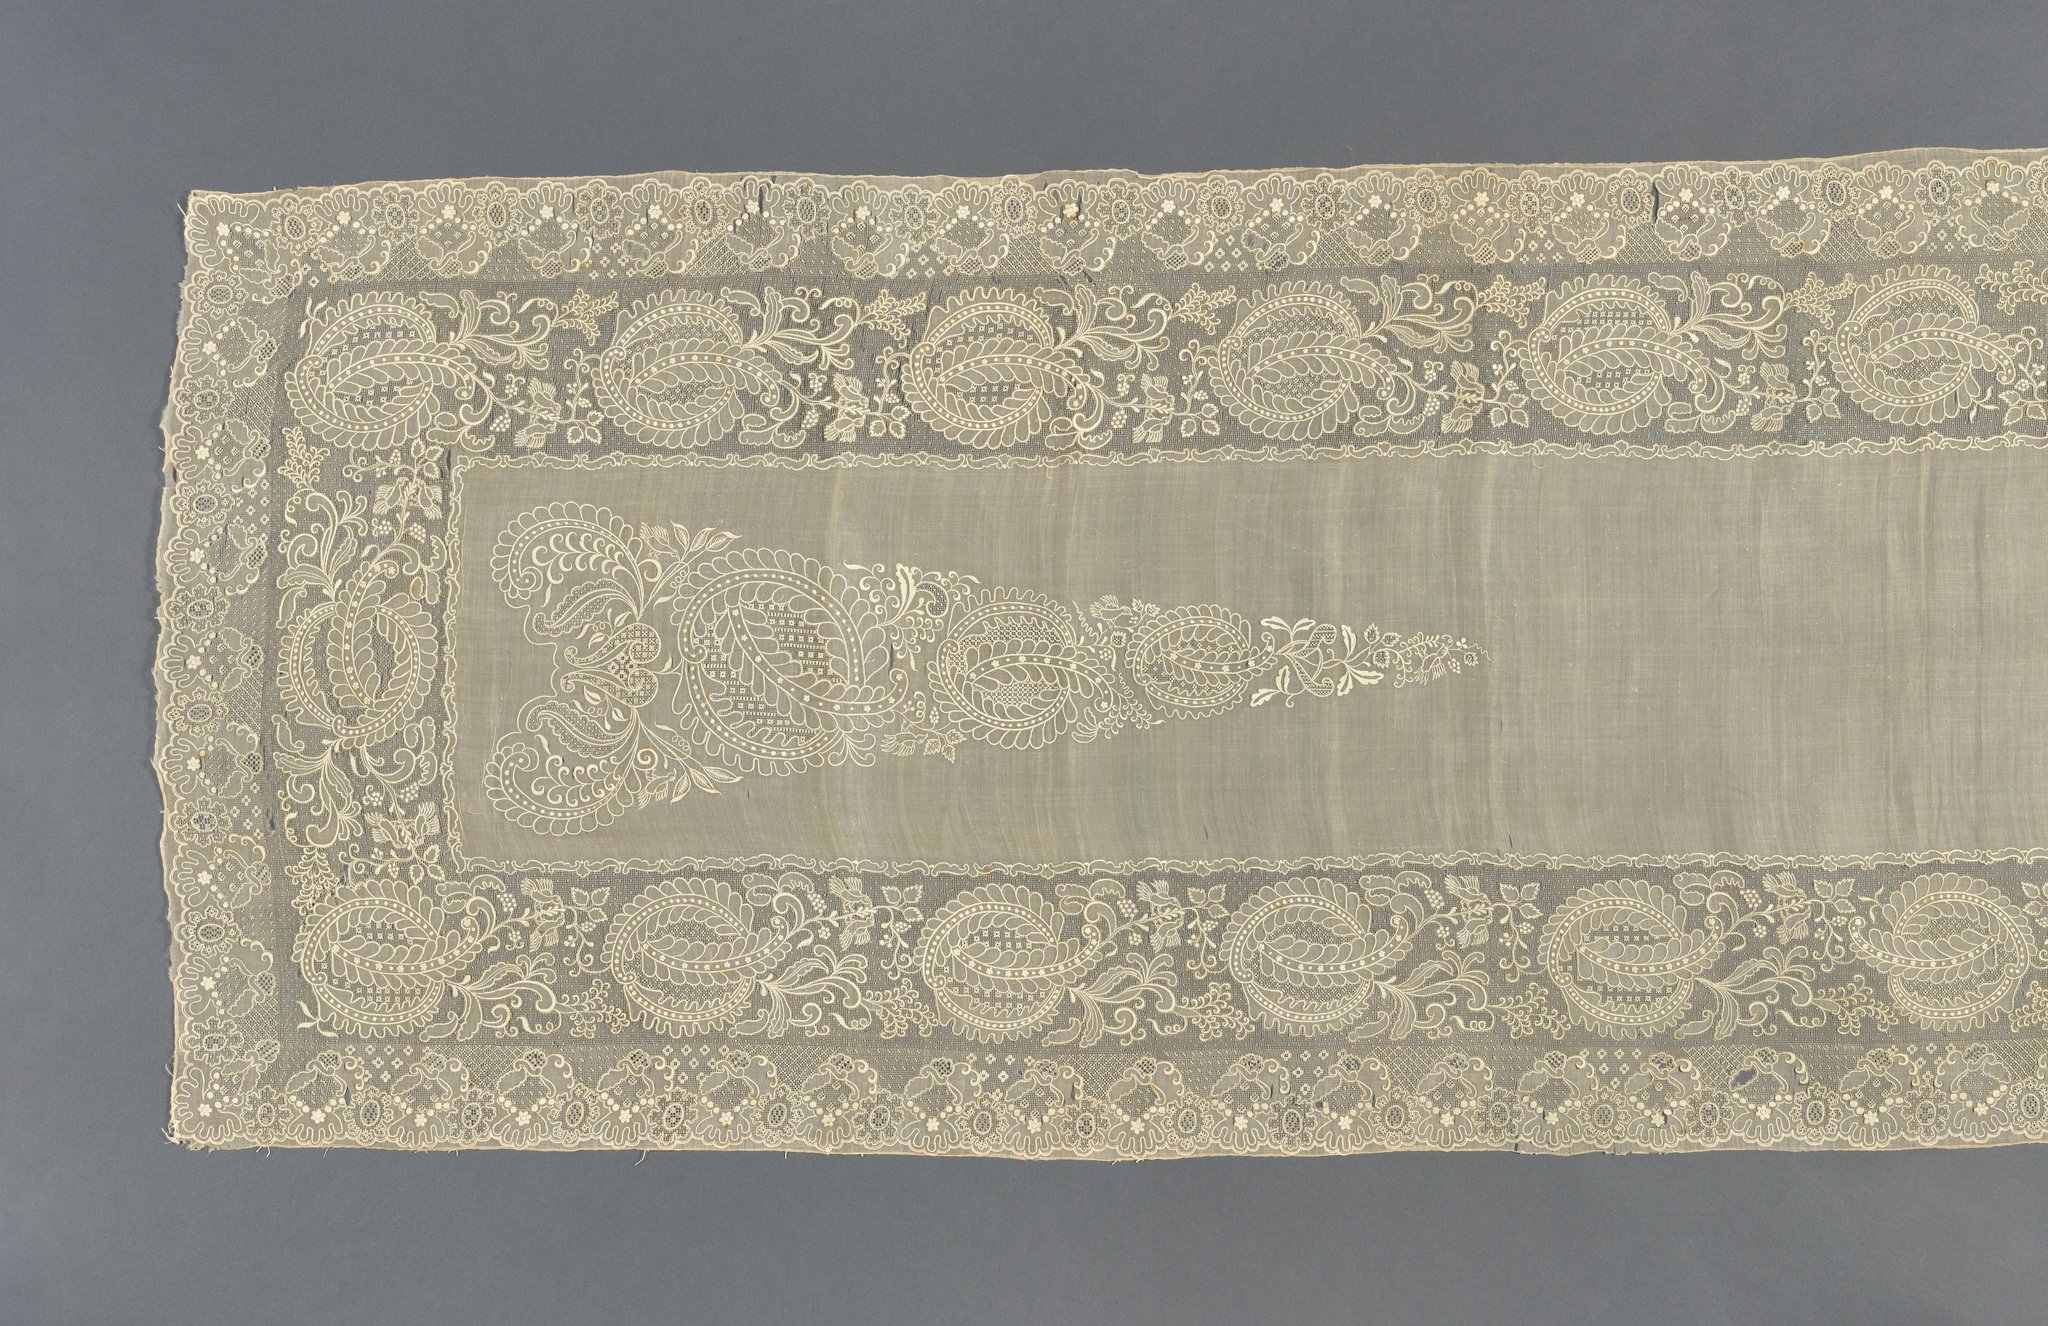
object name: cover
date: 1801-1900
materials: fiber, linen